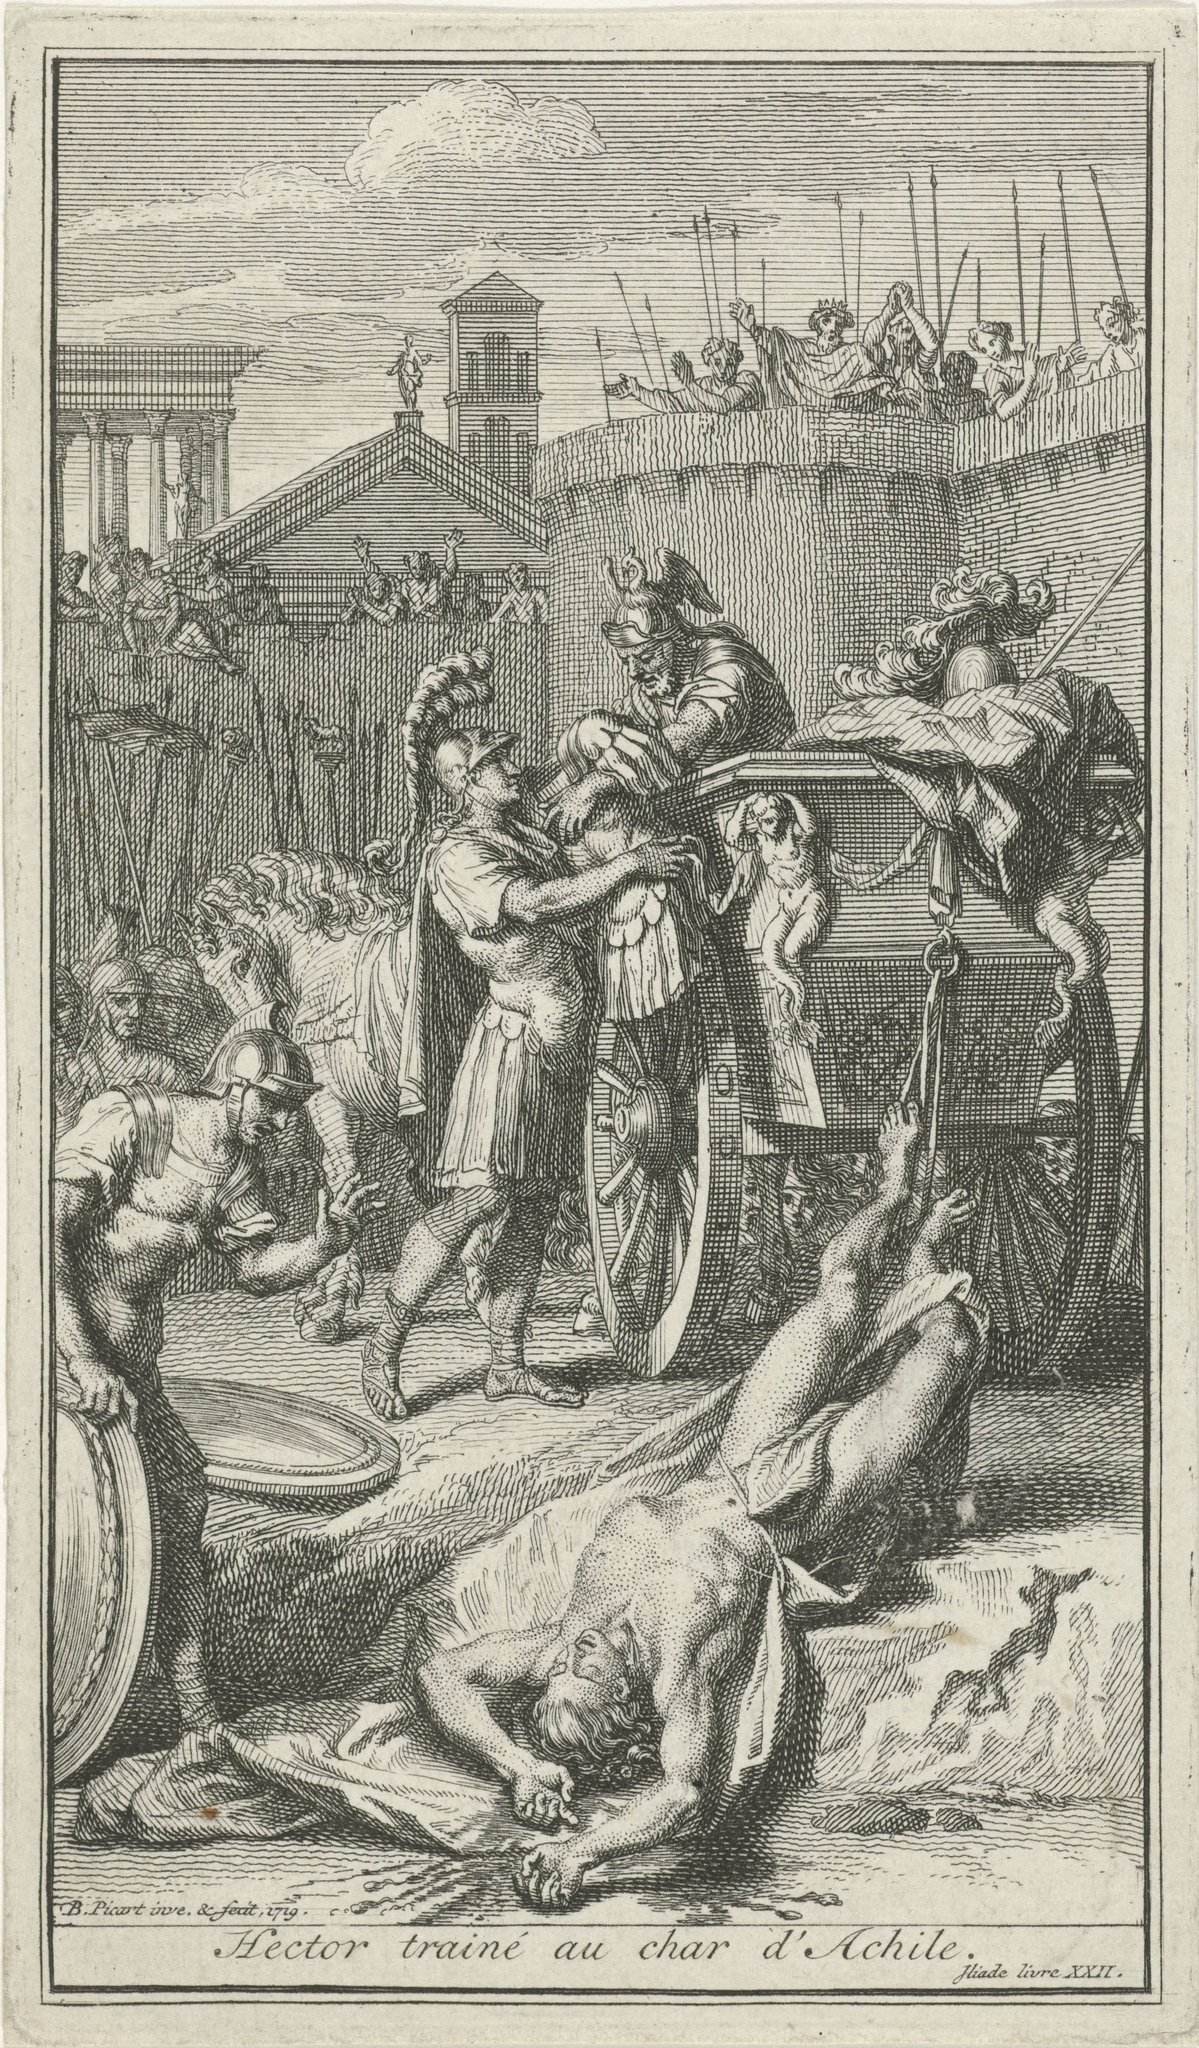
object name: print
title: Hector trainé au char d'Achile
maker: bernard picart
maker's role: draughtsman, print maker, publisher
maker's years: 1673-1733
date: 1719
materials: paper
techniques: engraving, etching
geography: amsterdam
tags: hector's body, tied to achilles' chariot, is dragged around the city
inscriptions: collector's mark: Lugt 240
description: Achilles sleept het lichaam van Hector, dat aan zijn wagen is gebonden, langs de muren van Troje. Andromache kijkt toe vanaf de stadsmuur.